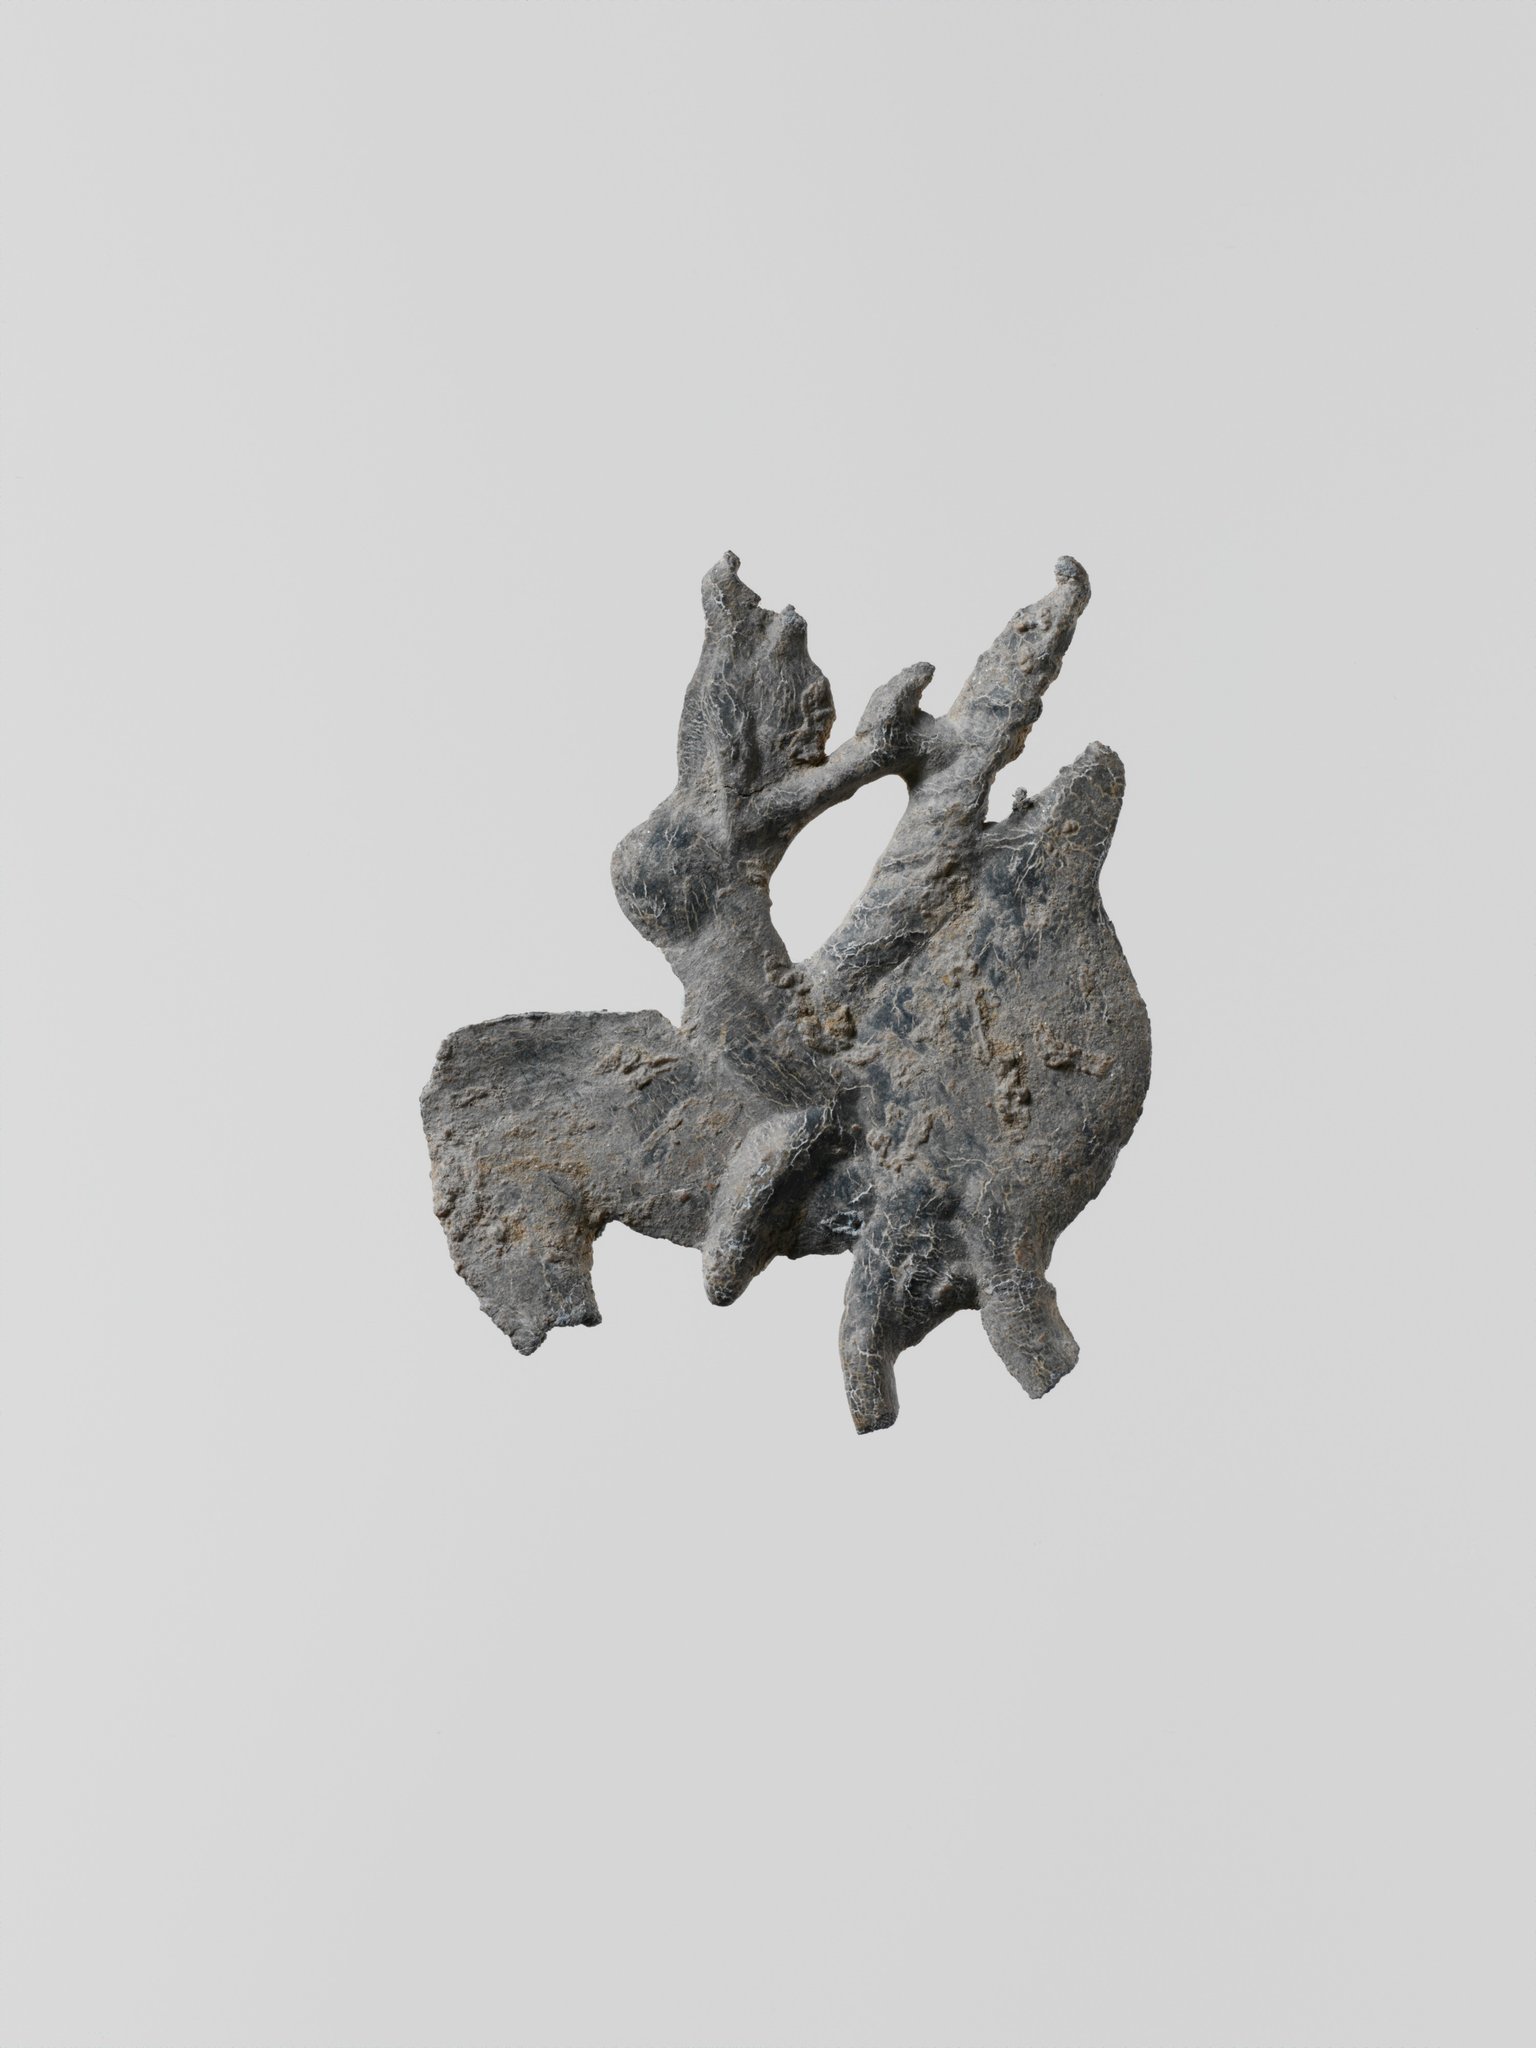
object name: statuette of a horse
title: Lead figure of a horseman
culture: greek, laconian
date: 600-401 BCE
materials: lead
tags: men,horses